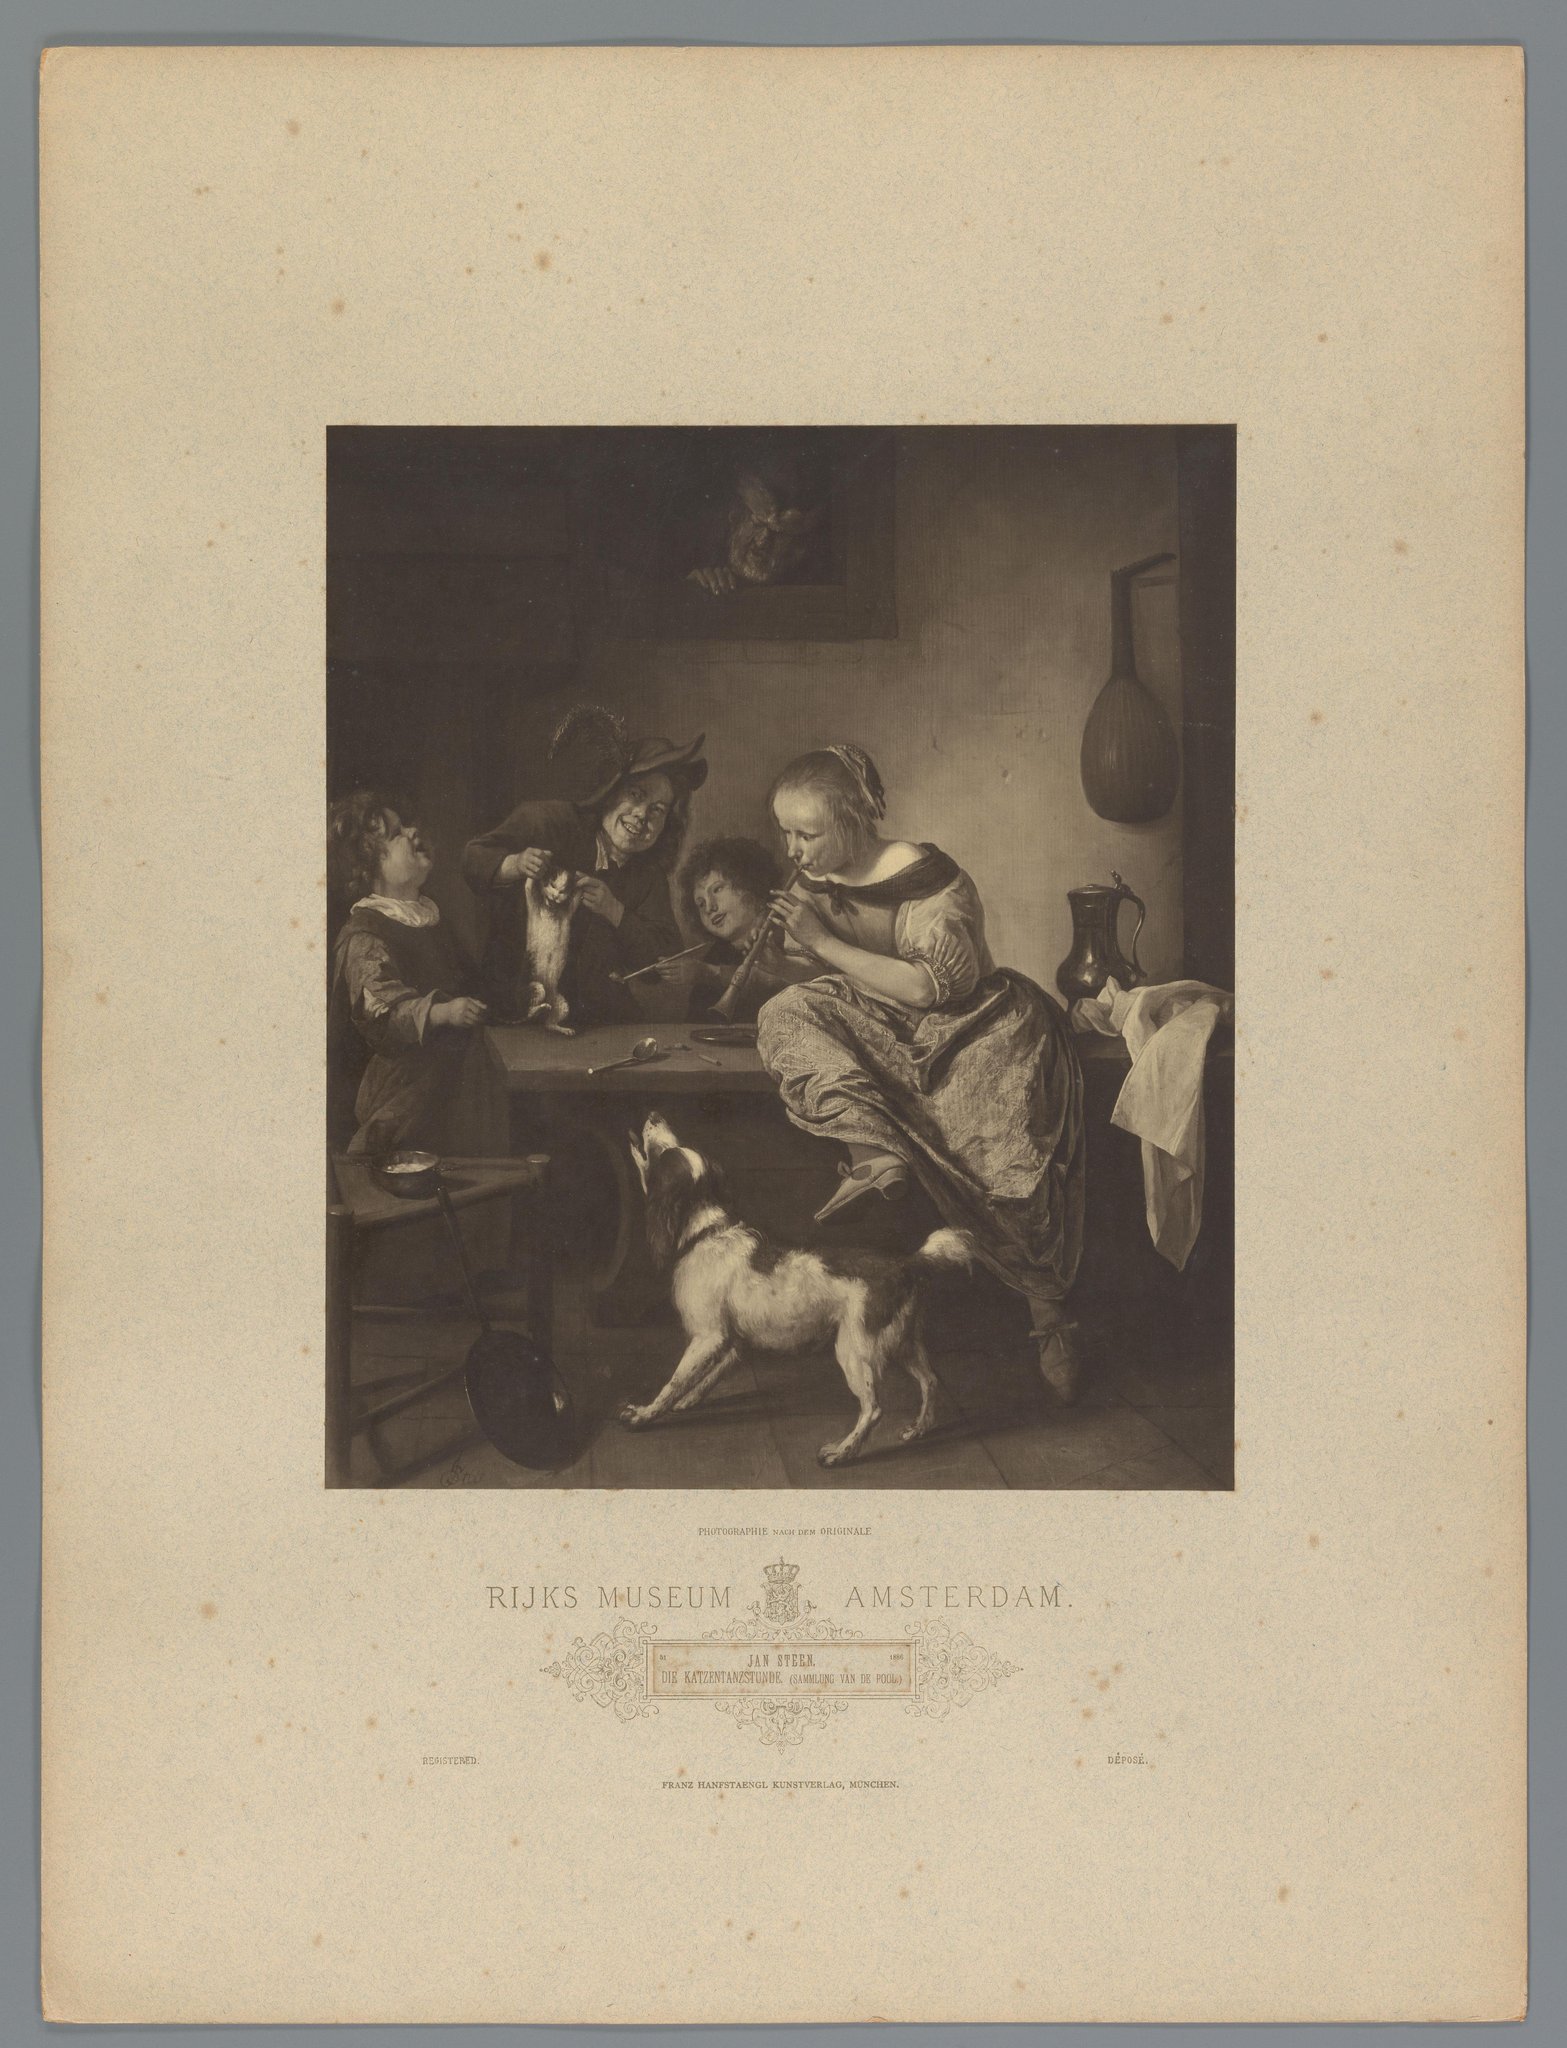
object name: reproduction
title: Jan Steen. Die Katzentanzstunde. (Sammlung Van de Pool.)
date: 1886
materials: cardboard, paper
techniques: carbon print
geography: amsterdam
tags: children playing musical instruments, child playing with animals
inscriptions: inscription: ‘Photographie nach dem Originale/ Rijks Museum Amsterdam/ Registered. Déposé.’, number: ‘51’